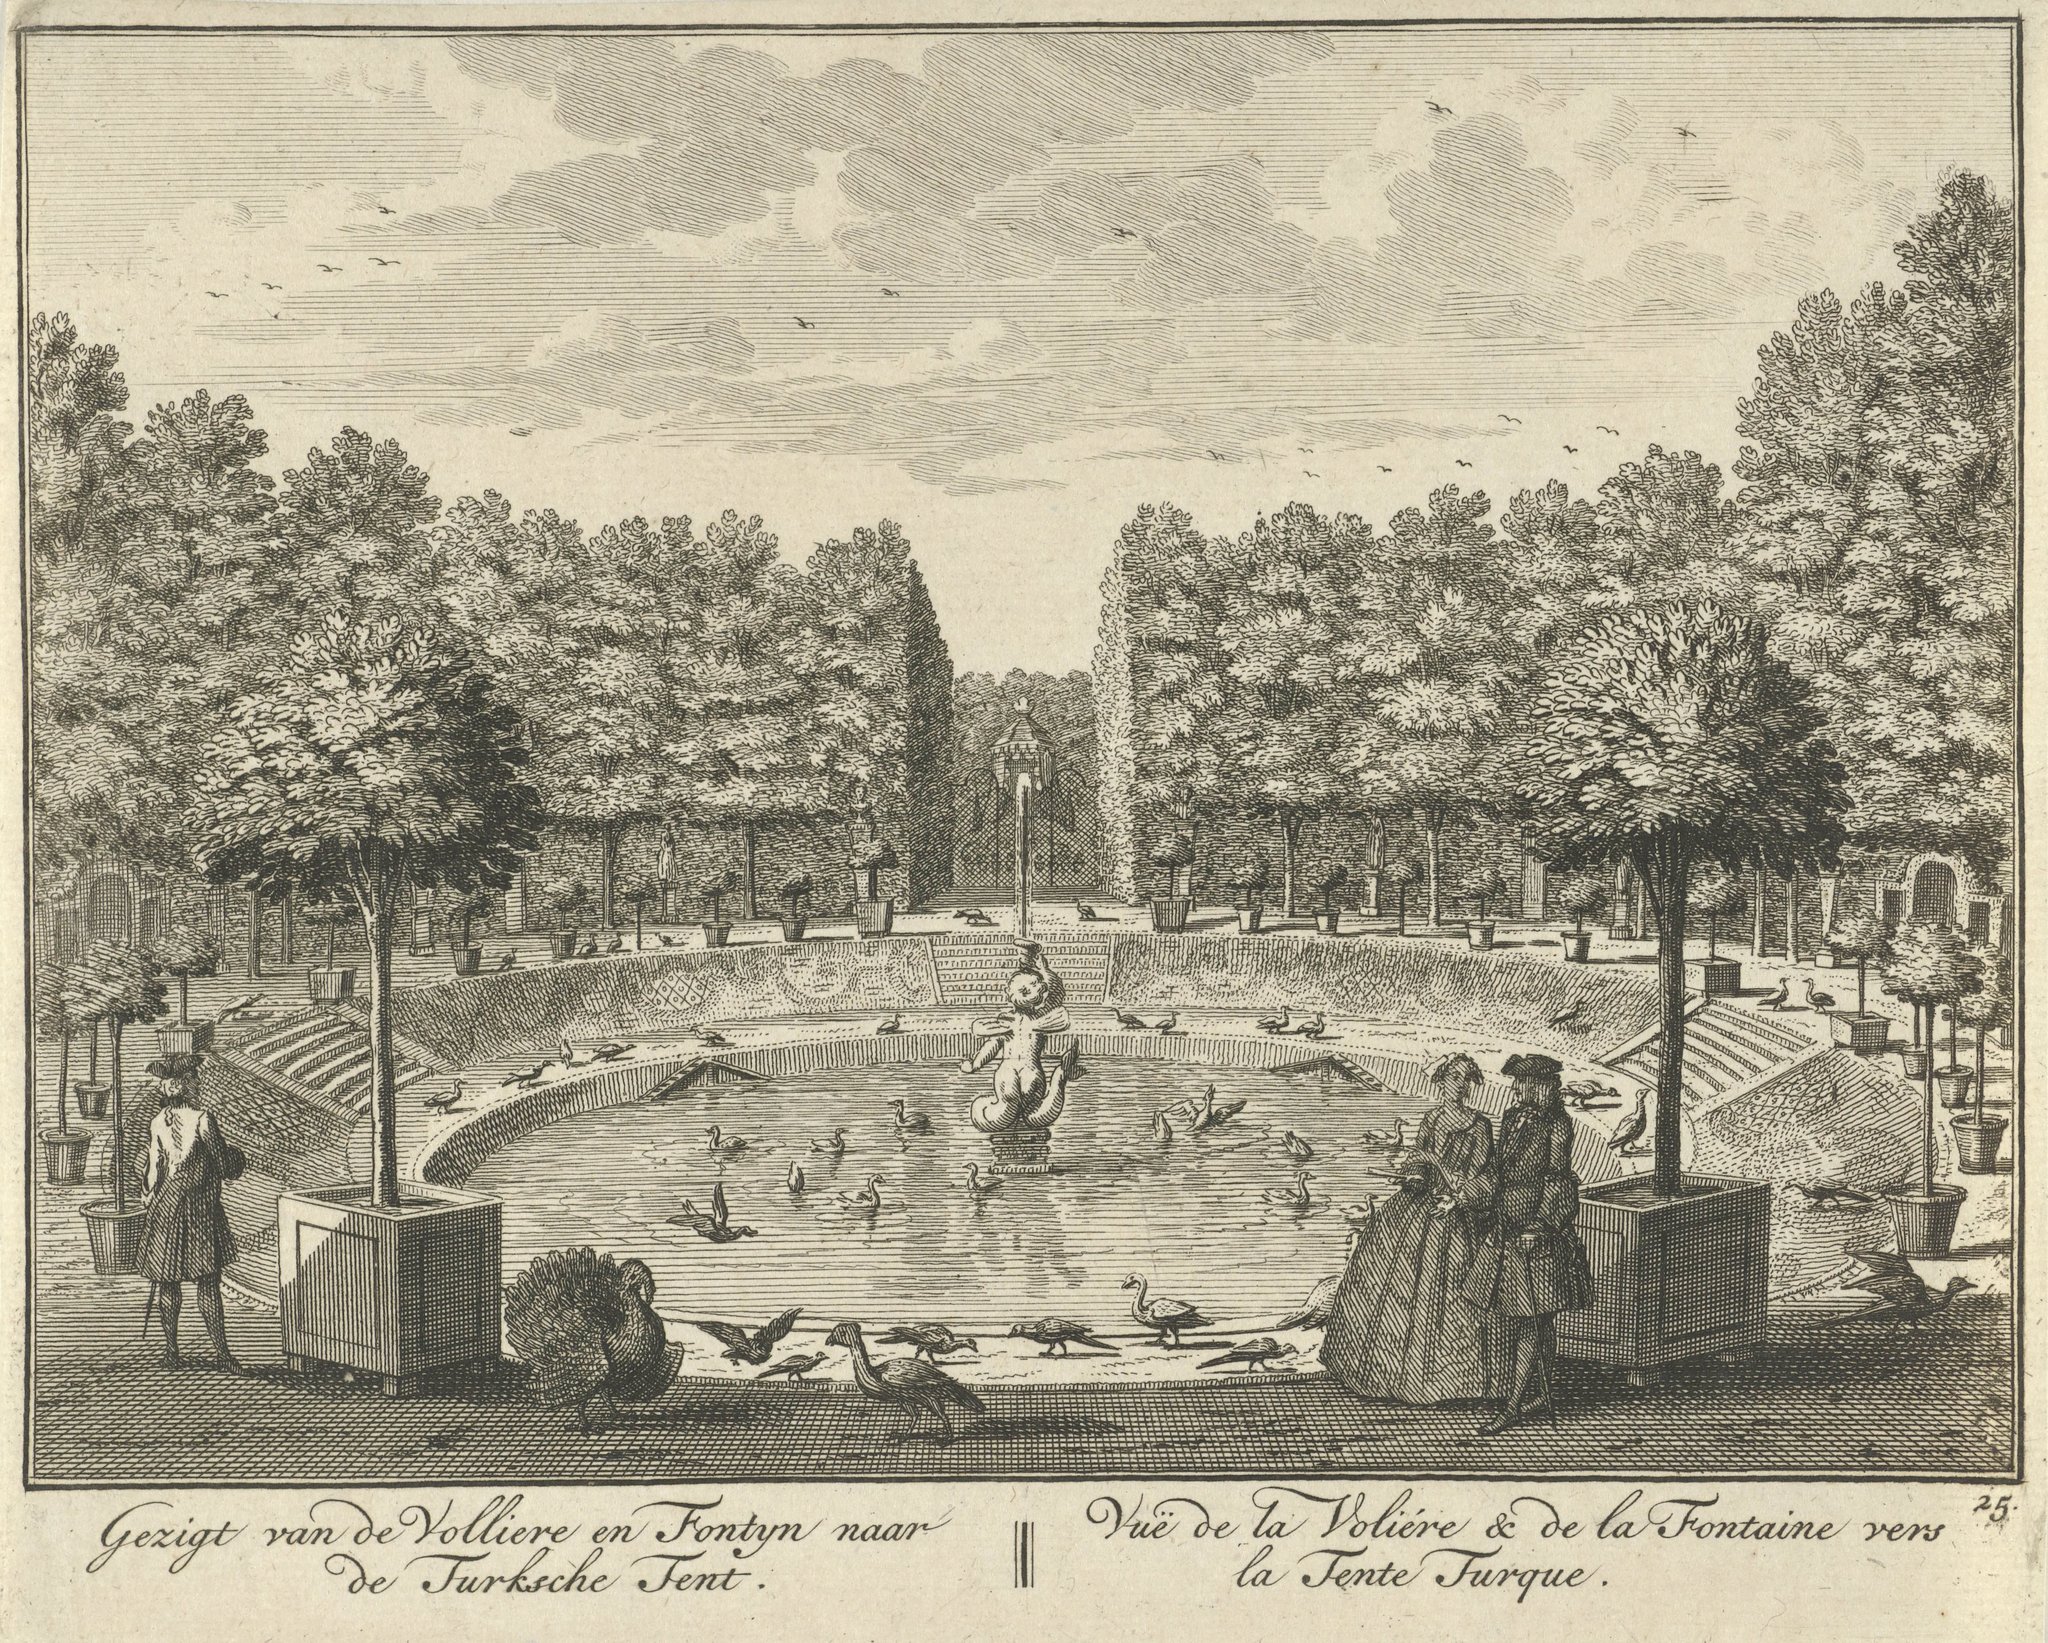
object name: print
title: Gezicht op de grote fontein en de Turkse Tent in de tuin van Huis ter Meer te Maarssen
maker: hendrik de leth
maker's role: draughtsman, print maker, publisher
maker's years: 1703-1766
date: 1740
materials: paper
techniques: etching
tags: garden fountain, french or architectonic garden; formal garden, groups of birds, country-house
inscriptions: collector's mark: Lugt 2228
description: Gezicht op de grote fontein en de Turkse Tent in de Franse tuin van Huis ter Meer. Rondom de fontein lopen diverse vogels. Op de voorgrond staan enkele figuren aan de rand van het bassin. De prent maakt deel uit van een serie met 26 gezichten op Huis ter Meer en het bijbehorende landgoed te Maarssen.